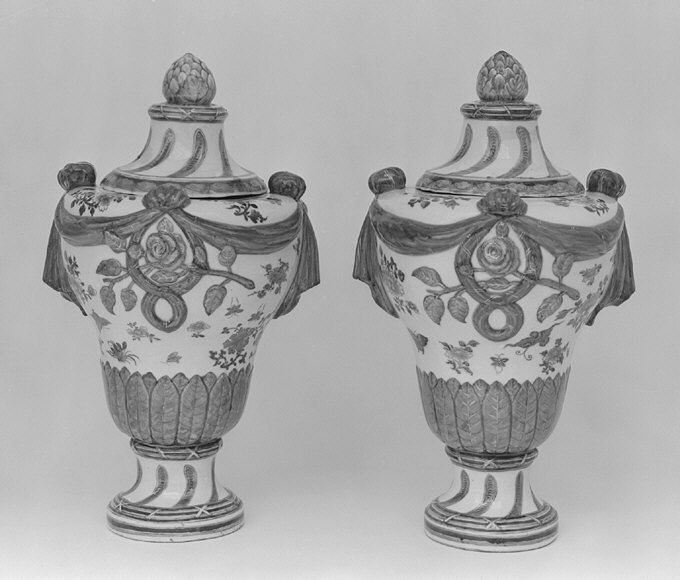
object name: urn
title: Pair of urns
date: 1775-1785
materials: hard paste porcelain